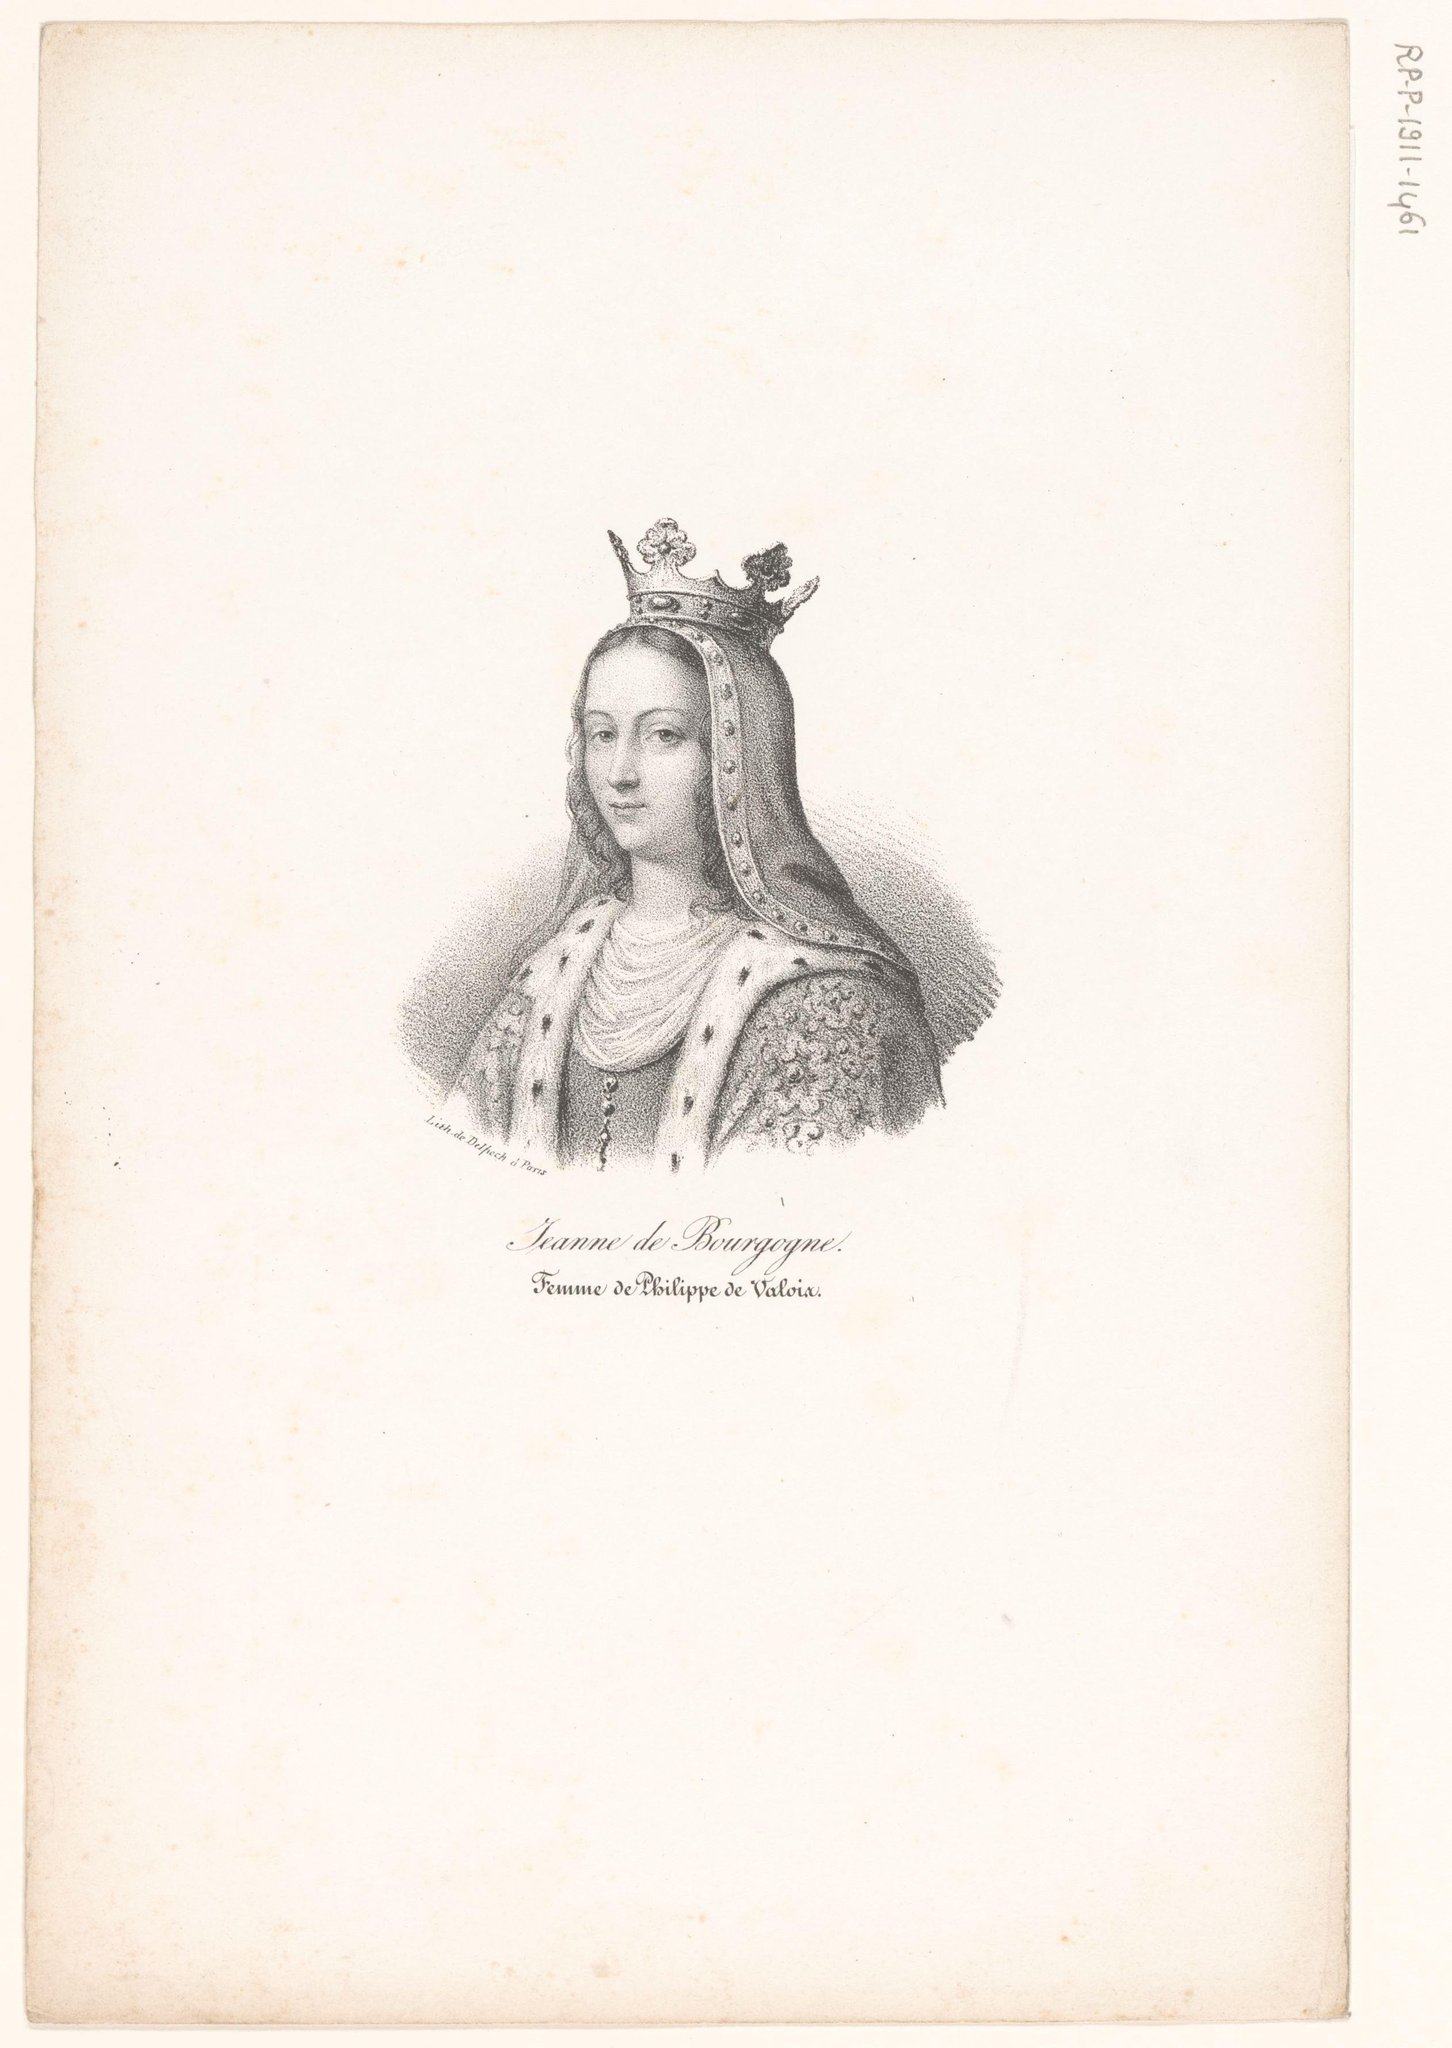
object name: print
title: Jeanne de Bourgogne, femme de Philippe de Valois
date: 1818-1842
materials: paper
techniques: lithograph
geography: paris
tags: historical persons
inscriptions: collector's mark: Lugt 2228a